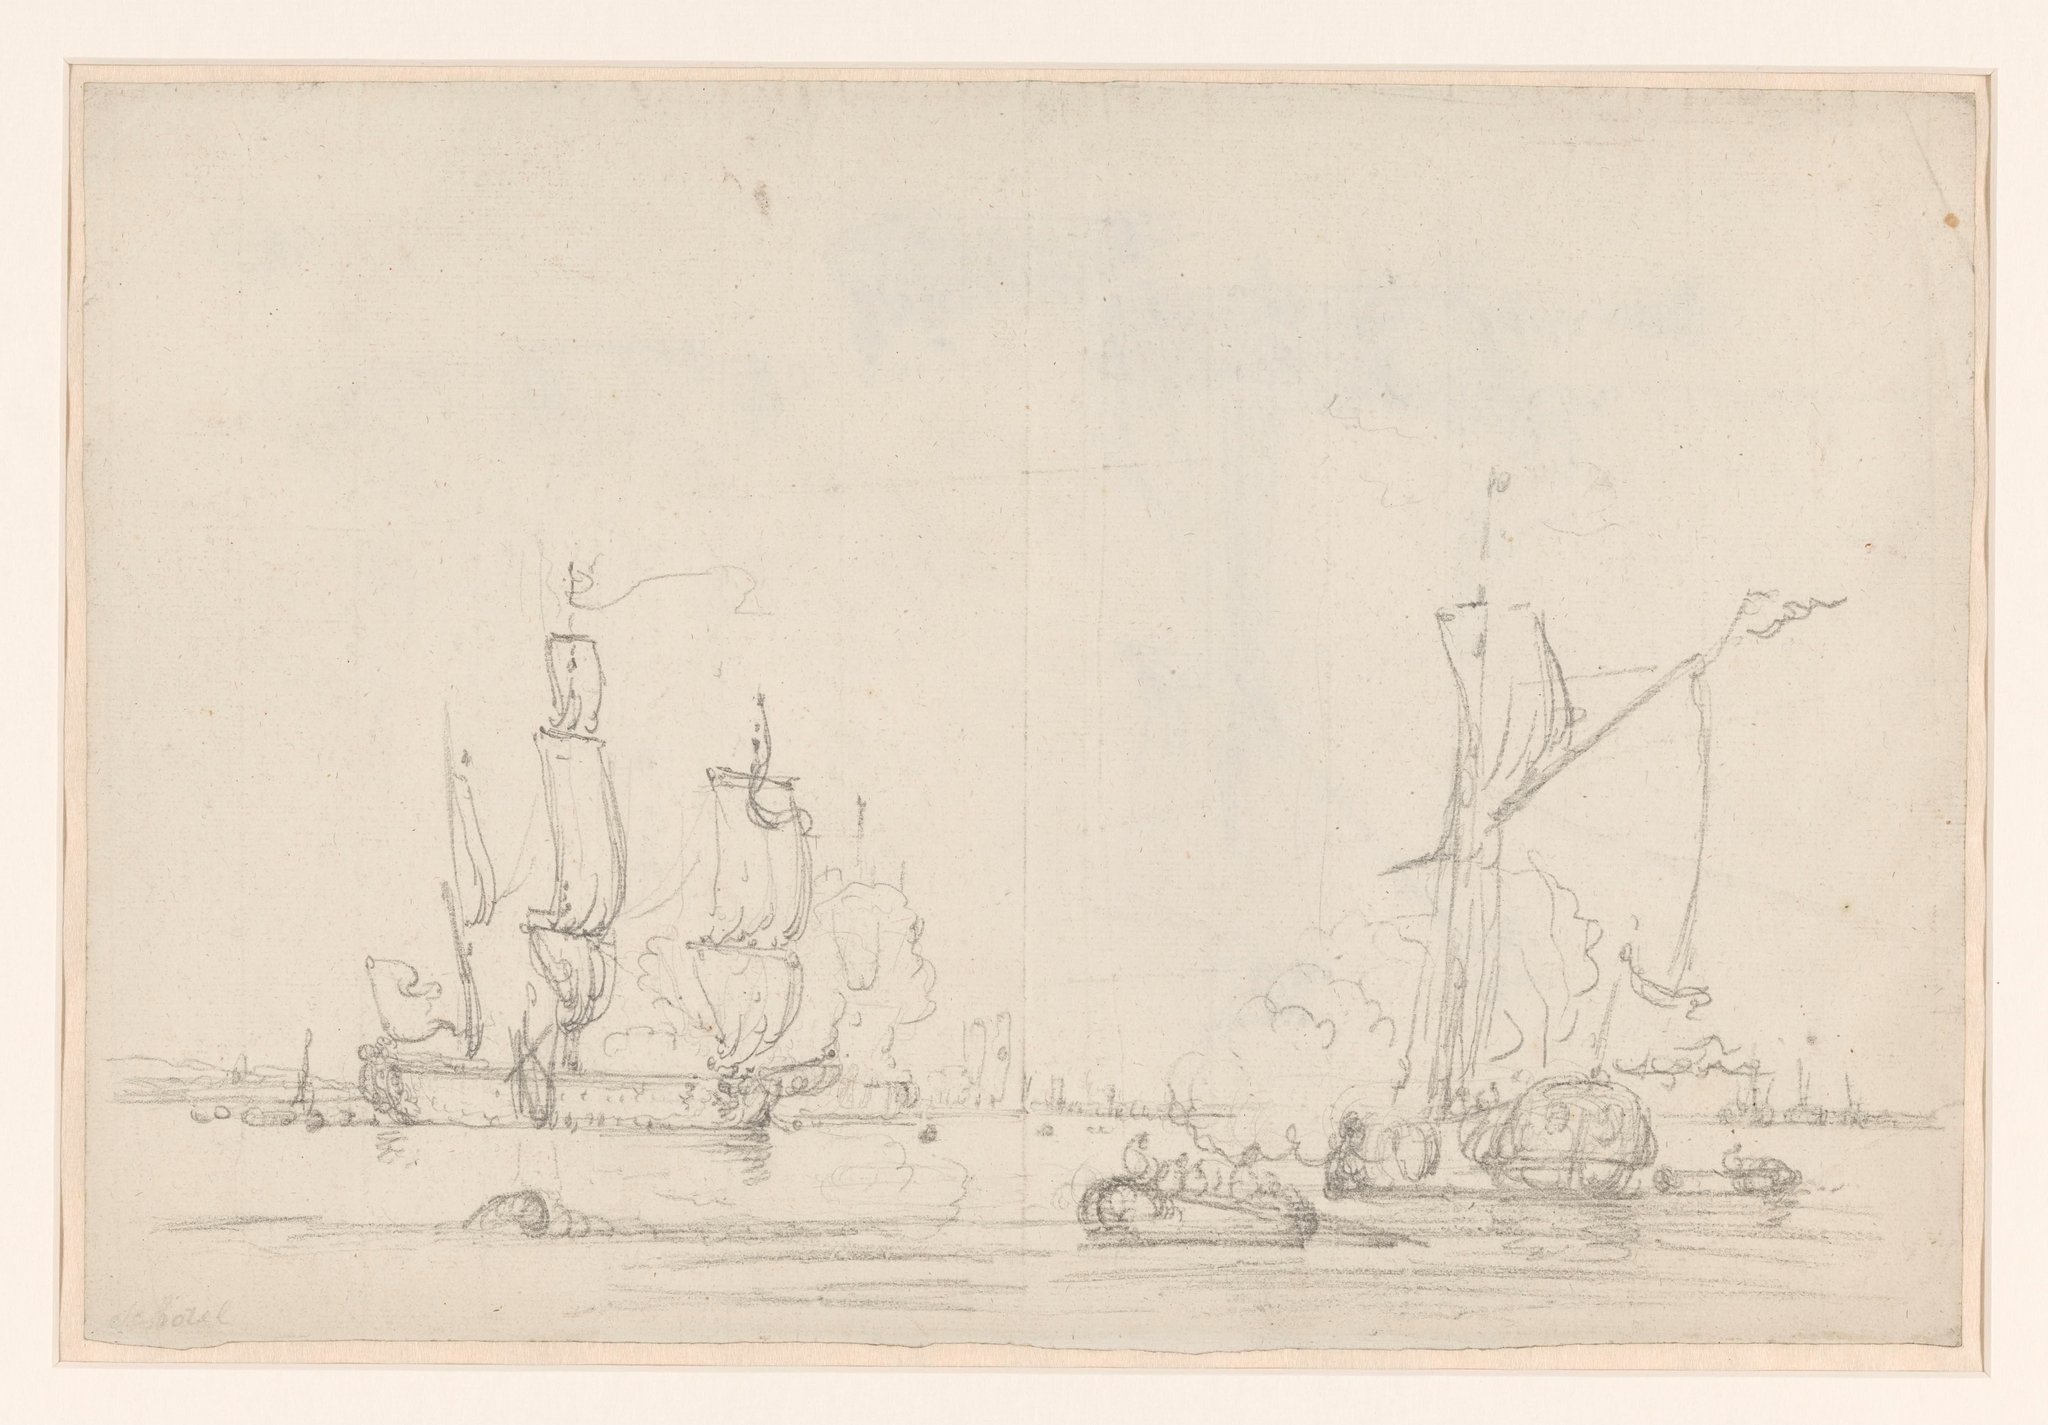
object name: drawing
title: Zeeslag, met links een driemaster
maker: johannes christiaan schotel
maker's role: draughtsman, painter, print maker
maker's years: 1787-1838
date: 1797-1838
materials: paper, pencil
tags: sailing-ship, sailing-boat, battle (+ naval force)